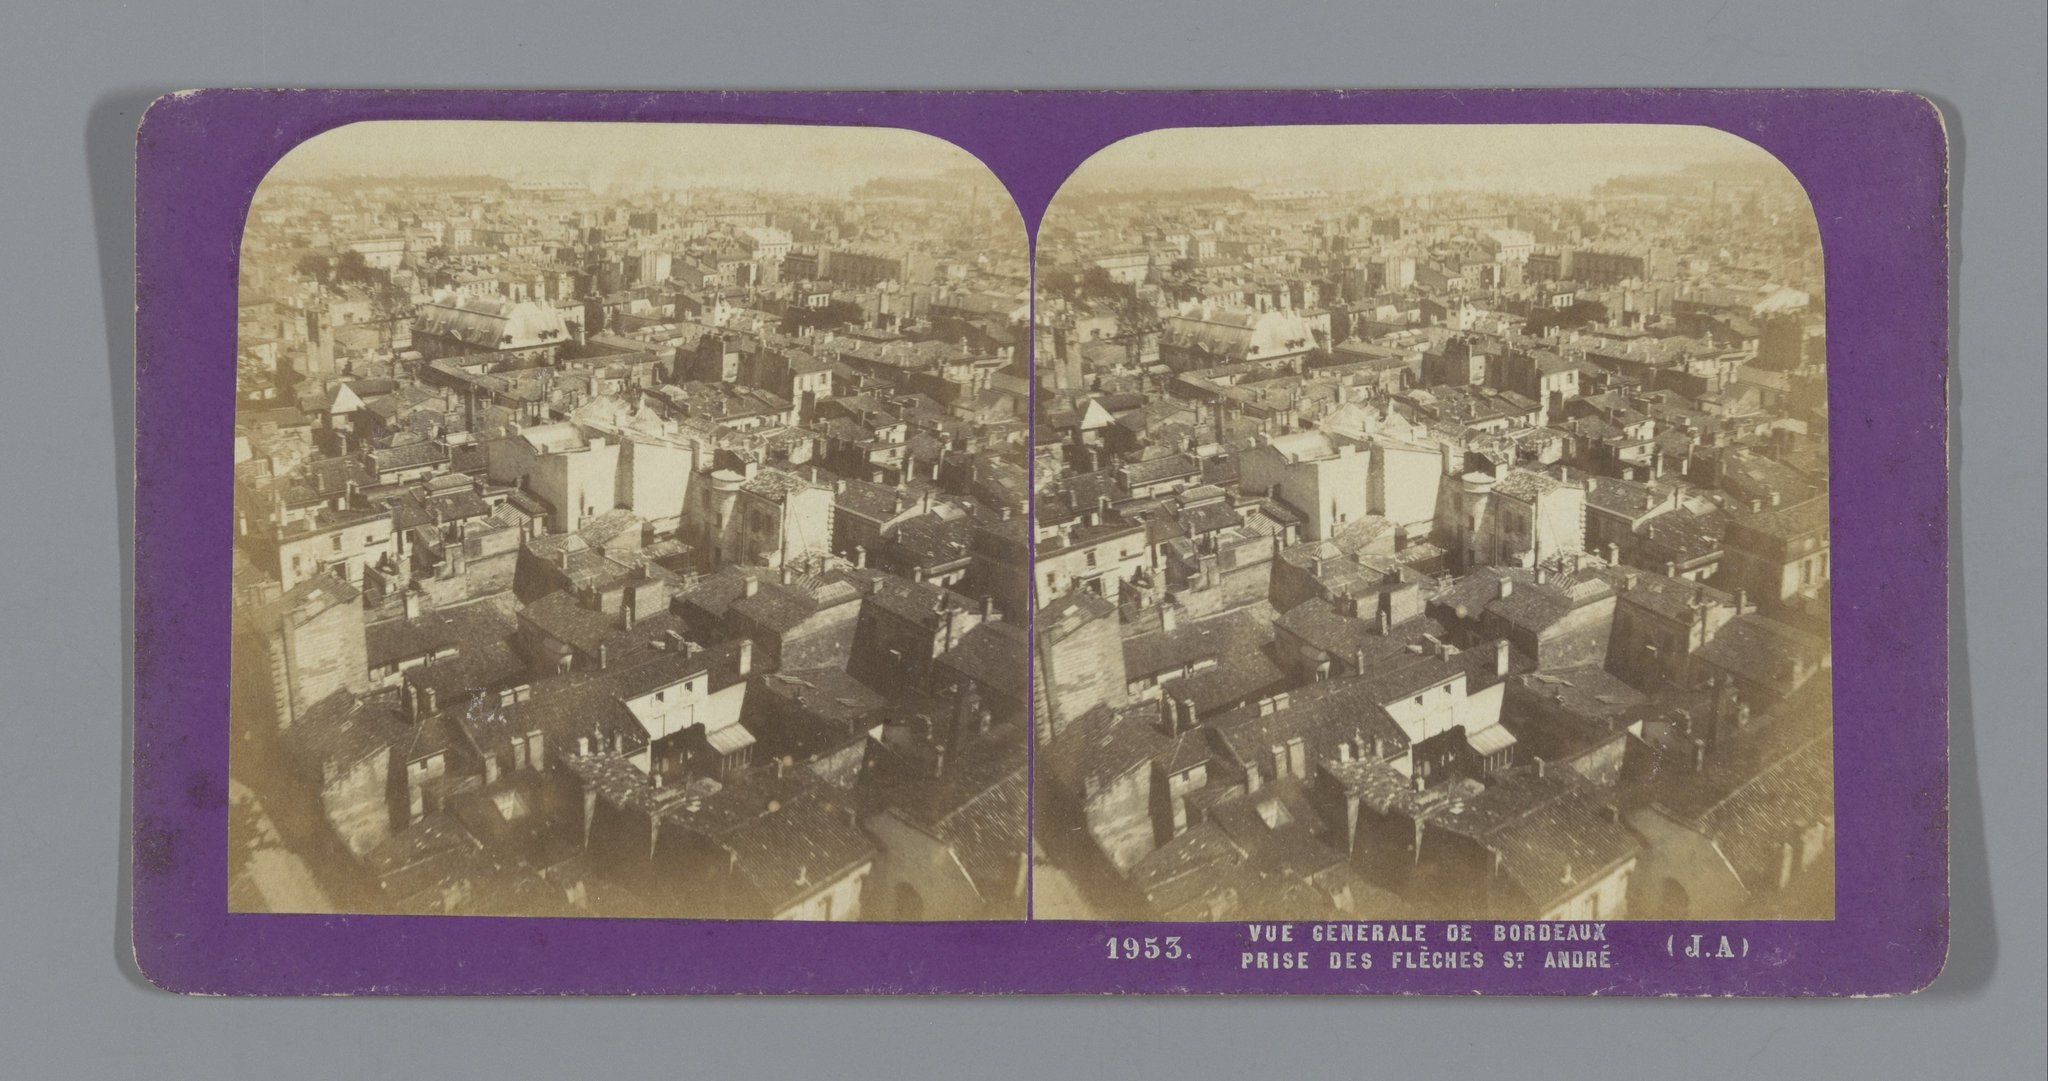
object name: stereograph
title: Gezicht op Bordeaux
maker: jean andrieu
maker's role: fotograaf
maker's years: 1816-1872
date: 1862-1876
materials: cardboard, photographic support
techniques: albumen print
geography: bordeaux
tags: bordeaux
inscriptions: number: ‘1953.’